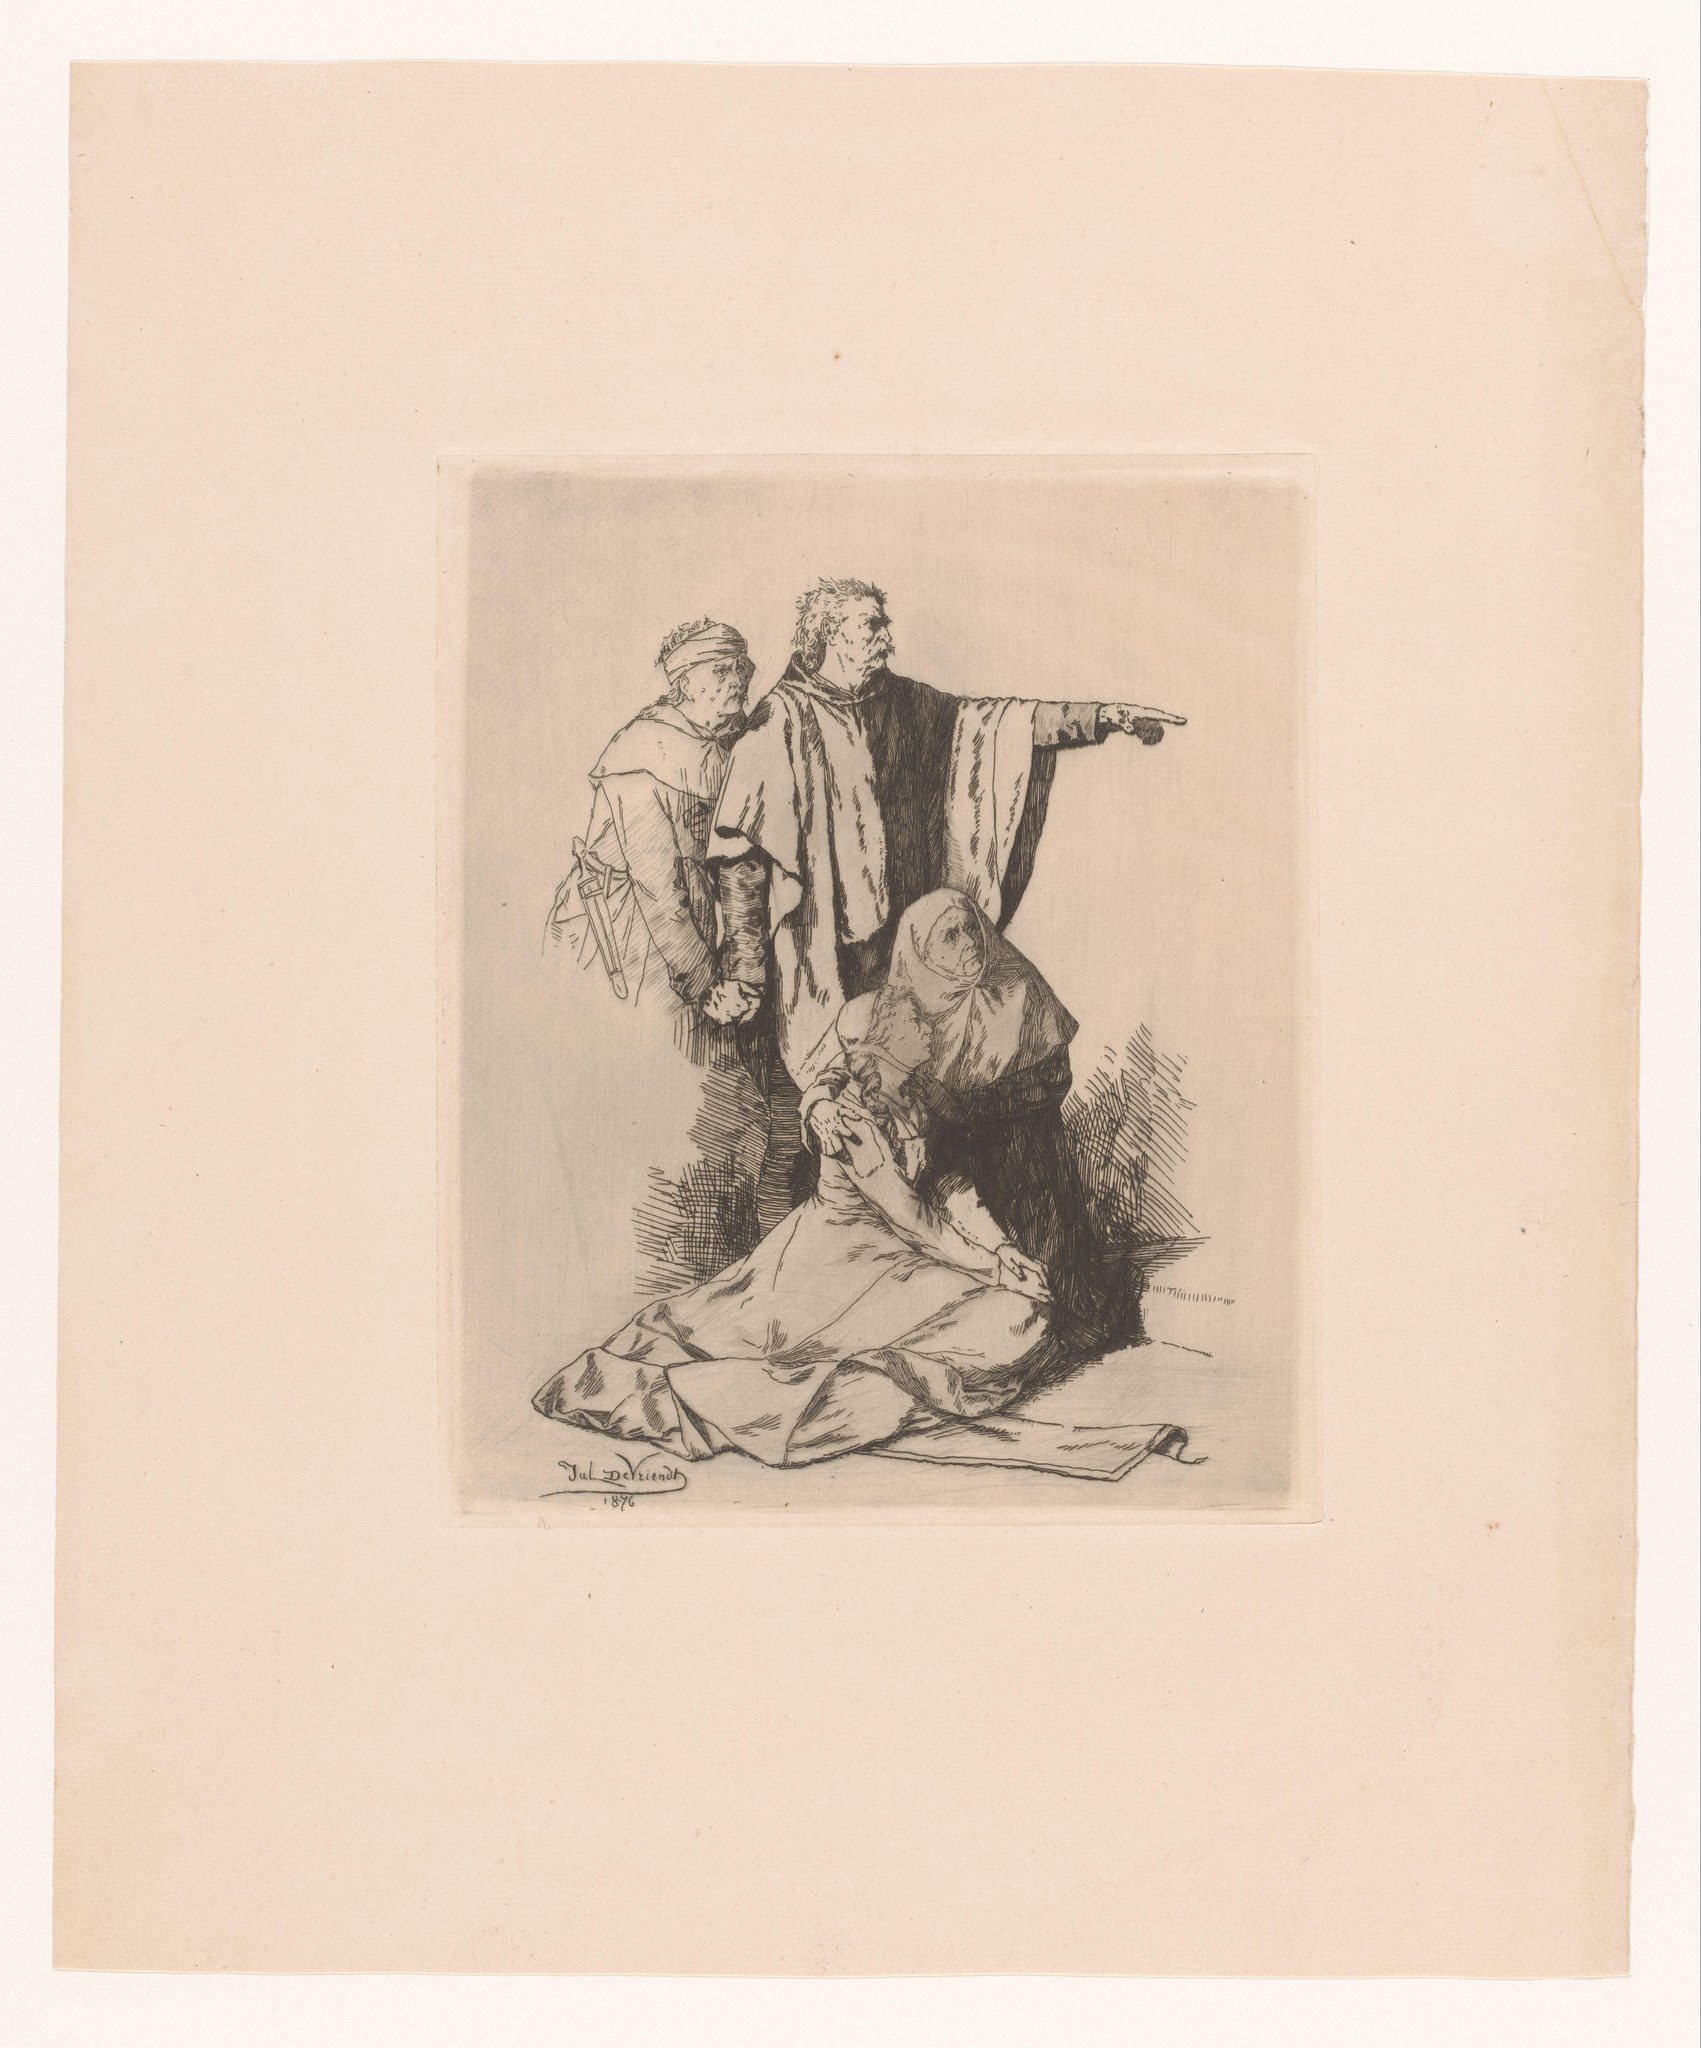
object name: print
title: Twee mannen waarvan één wijzend staande achter twee vrouwen gezeten op de grond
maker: juliaan de vriendt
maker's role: print maker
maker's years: 1842-1935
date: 1876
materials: paper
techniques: etching, intaglio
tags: the accused, adult man (+ two persons), adolescent, young woman, maiden, old woman, index finger forwards, pointing, indicating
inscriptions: collector's mark: Lugt 2228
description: Latere staat van deze prent is verschenen in: Album du journal des Beaux-Arts, dix eaux-fortes inédites. Brussel, Parijs en Leipzig: S.n., 1876. Op voorblad van de publicatie getiteld: Justice de Baudouin à la Hache. De scène is een detail uit een schilderij van Juliaan de Vriendt waarop Boudewijn VII van Vlaanderen een edelman veroordeelt.